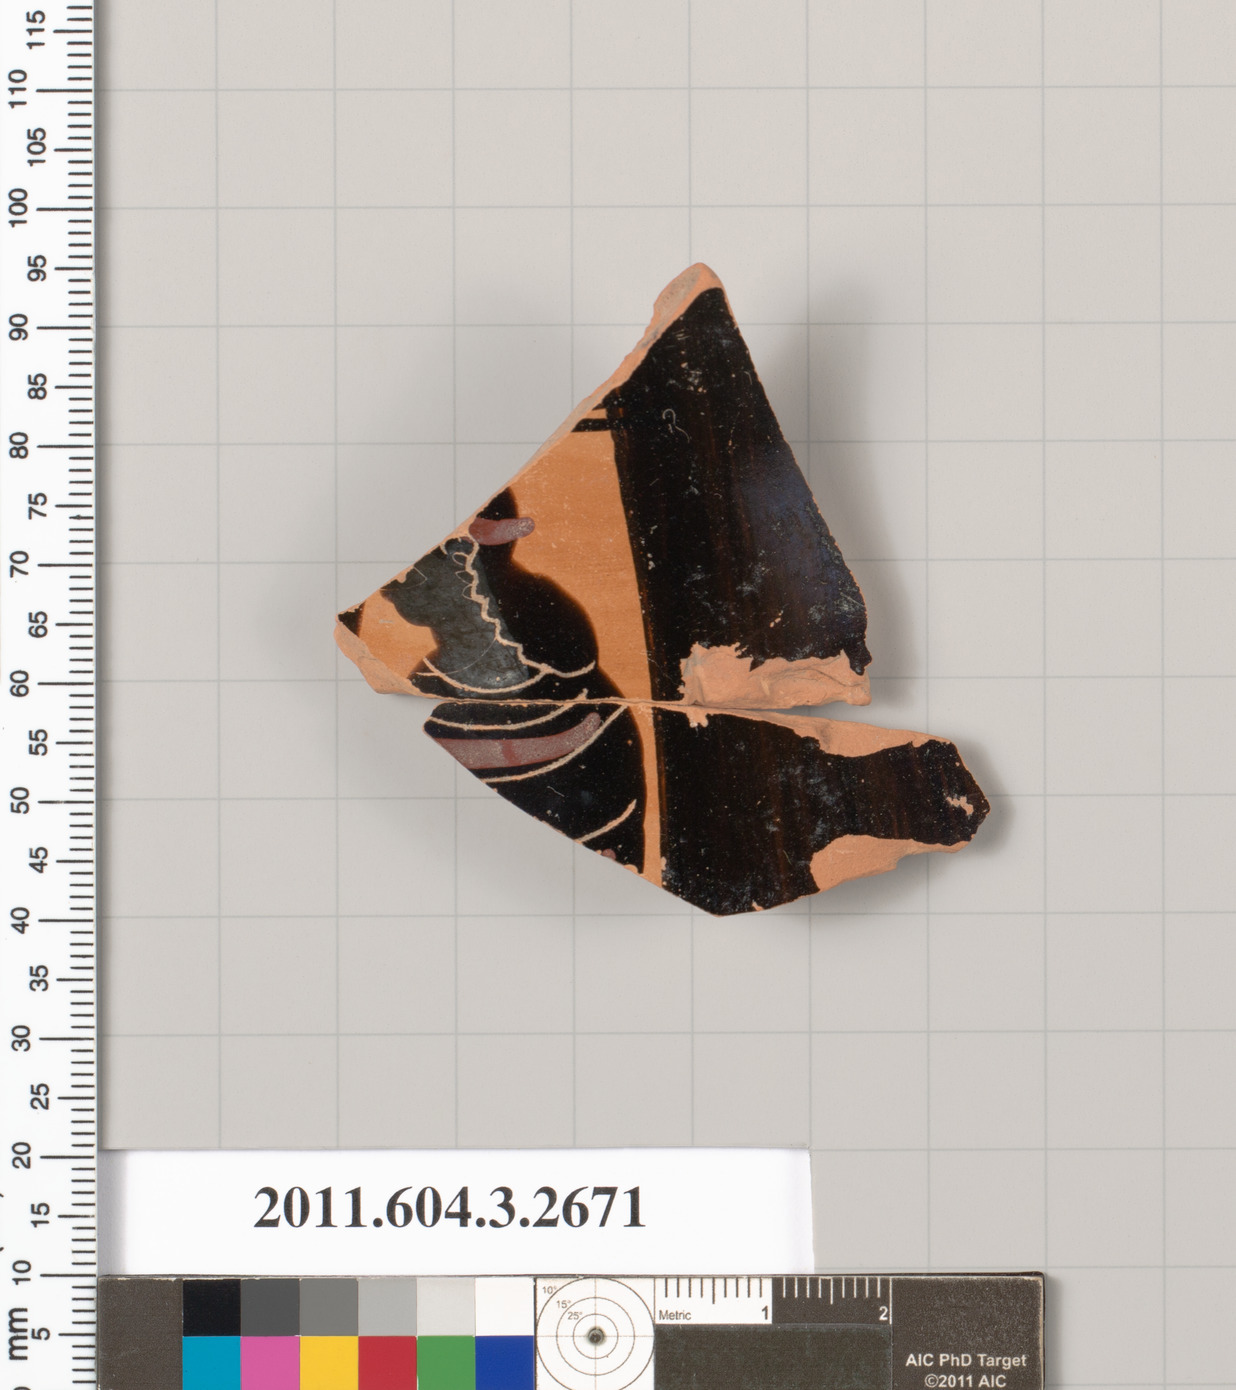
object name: olpe fragment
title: Terracotta fragment of an olpe (jug)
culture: greek, attic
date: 534-468 BCE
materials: terracotta